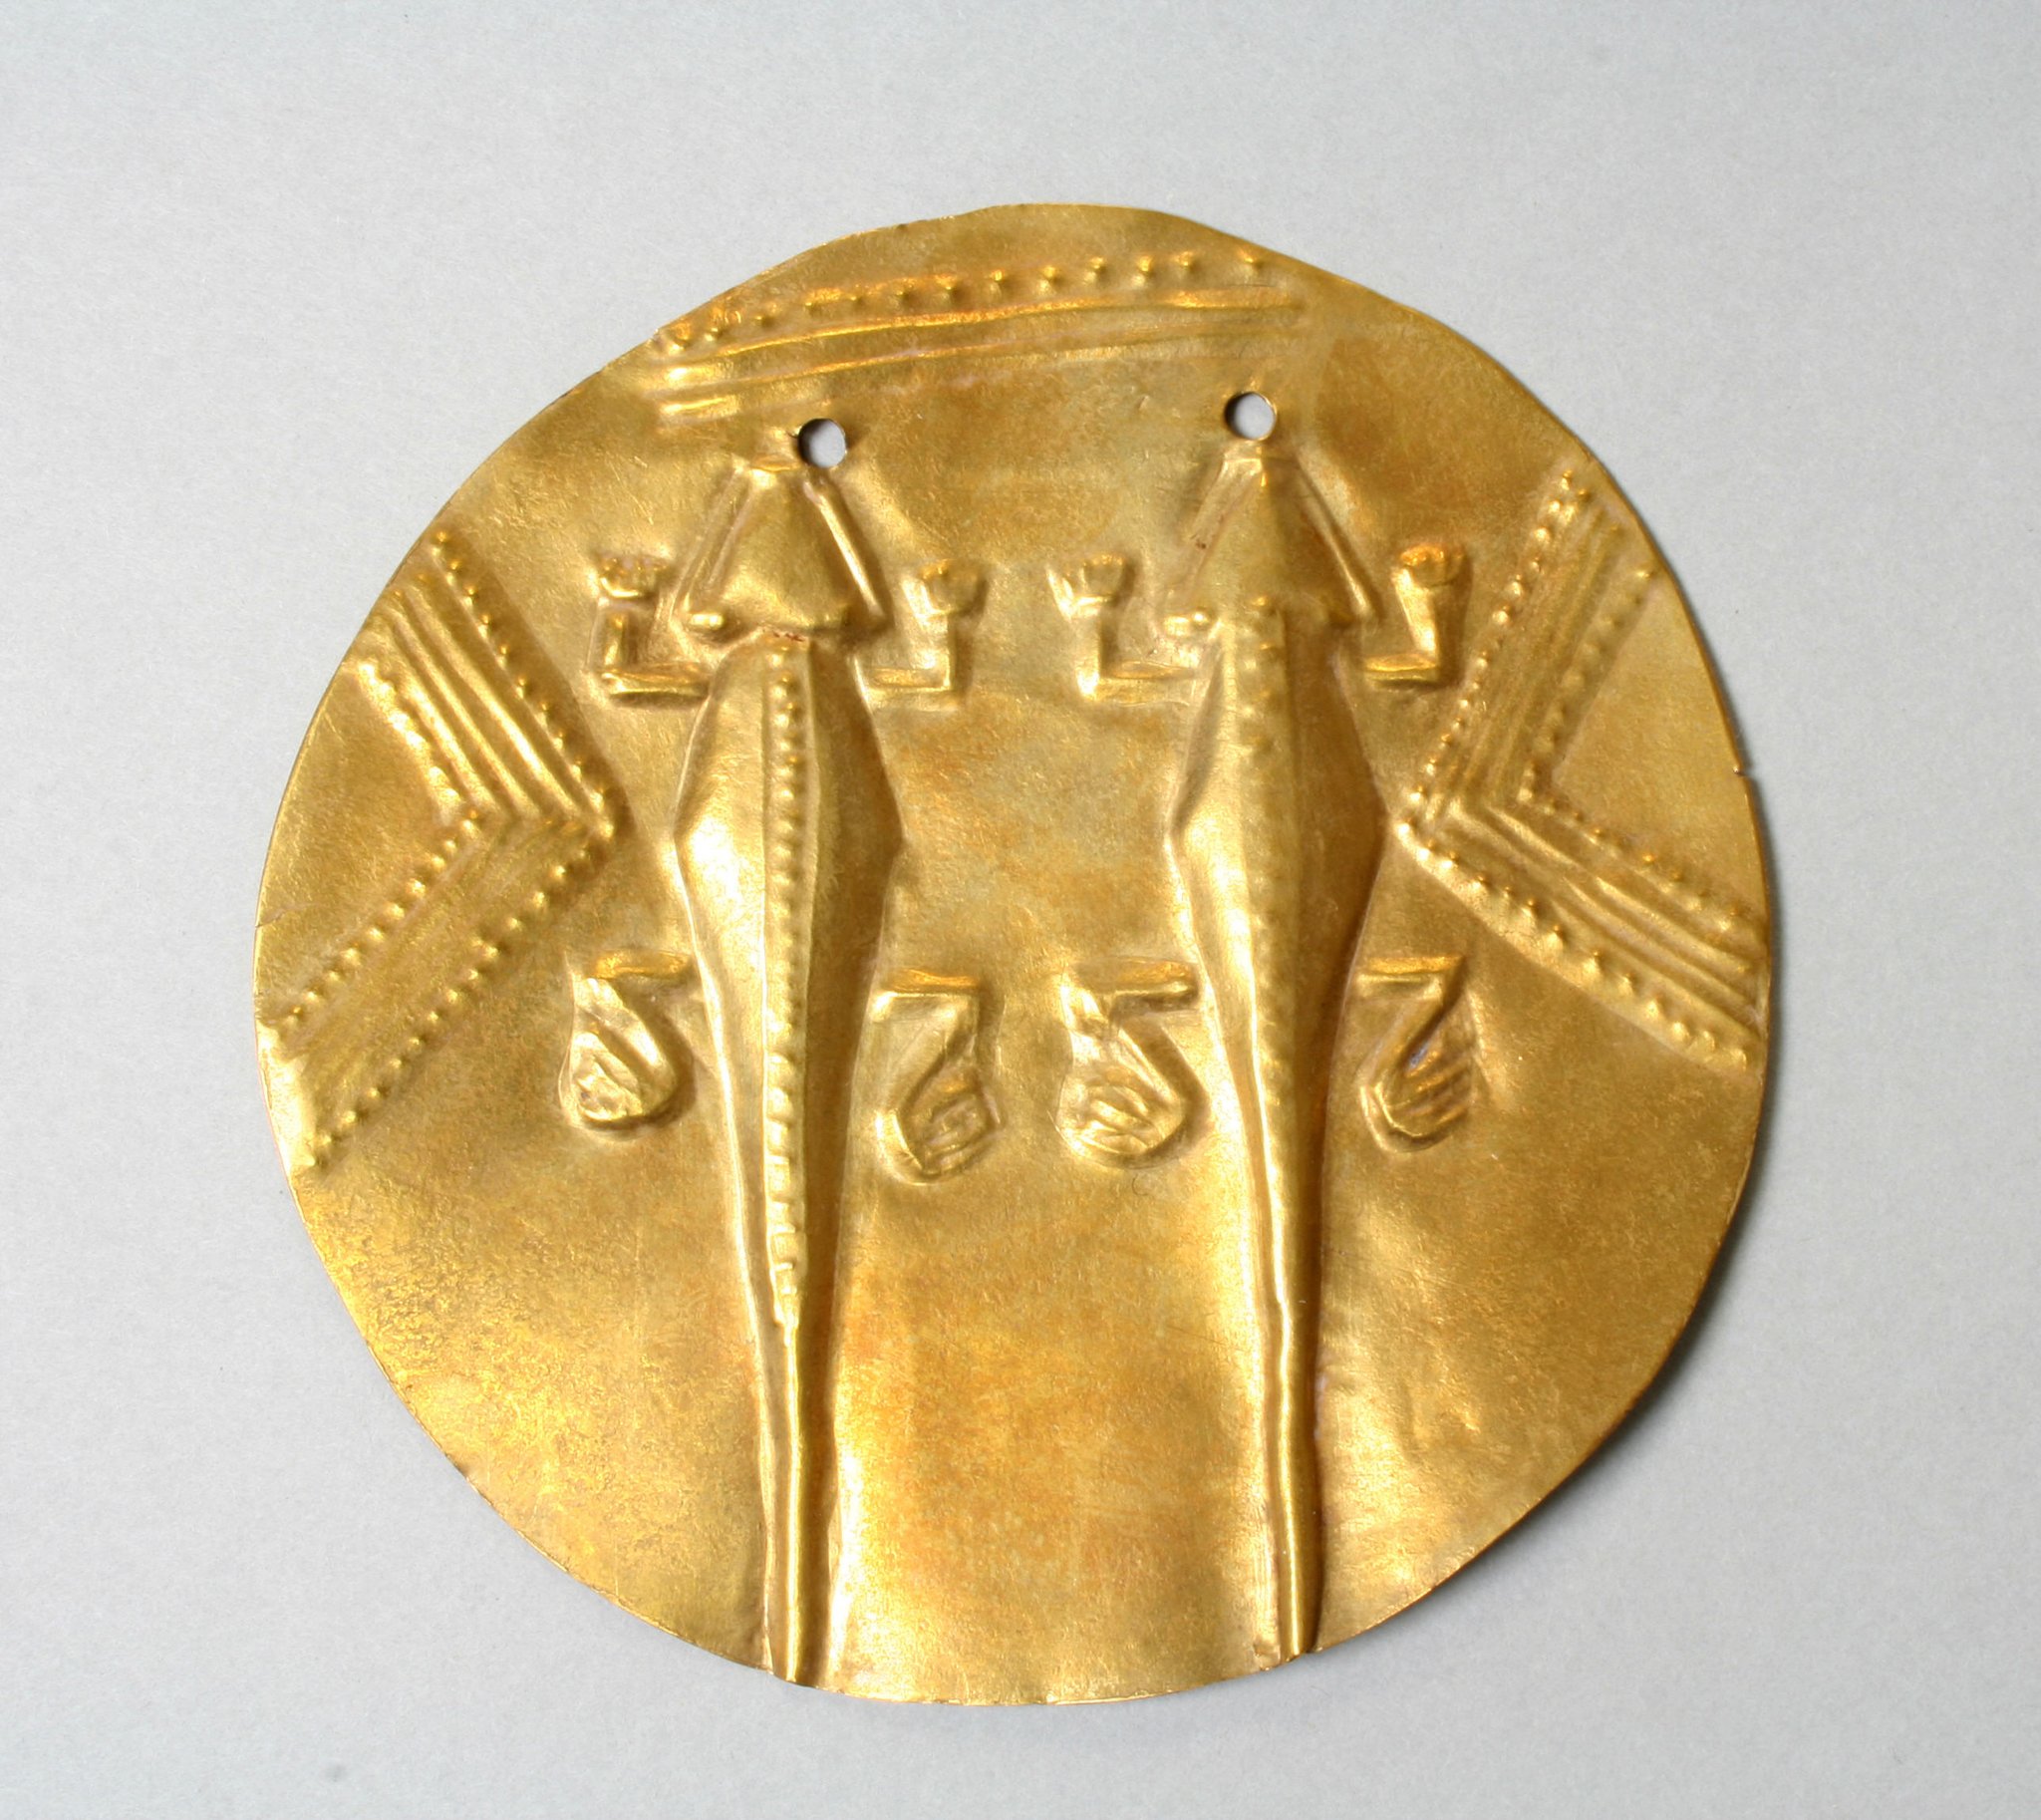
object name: pectoral disk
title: Pectoral Disk (Patena)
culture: veraguas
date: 1001-1600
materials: gold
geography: panama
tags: lizards